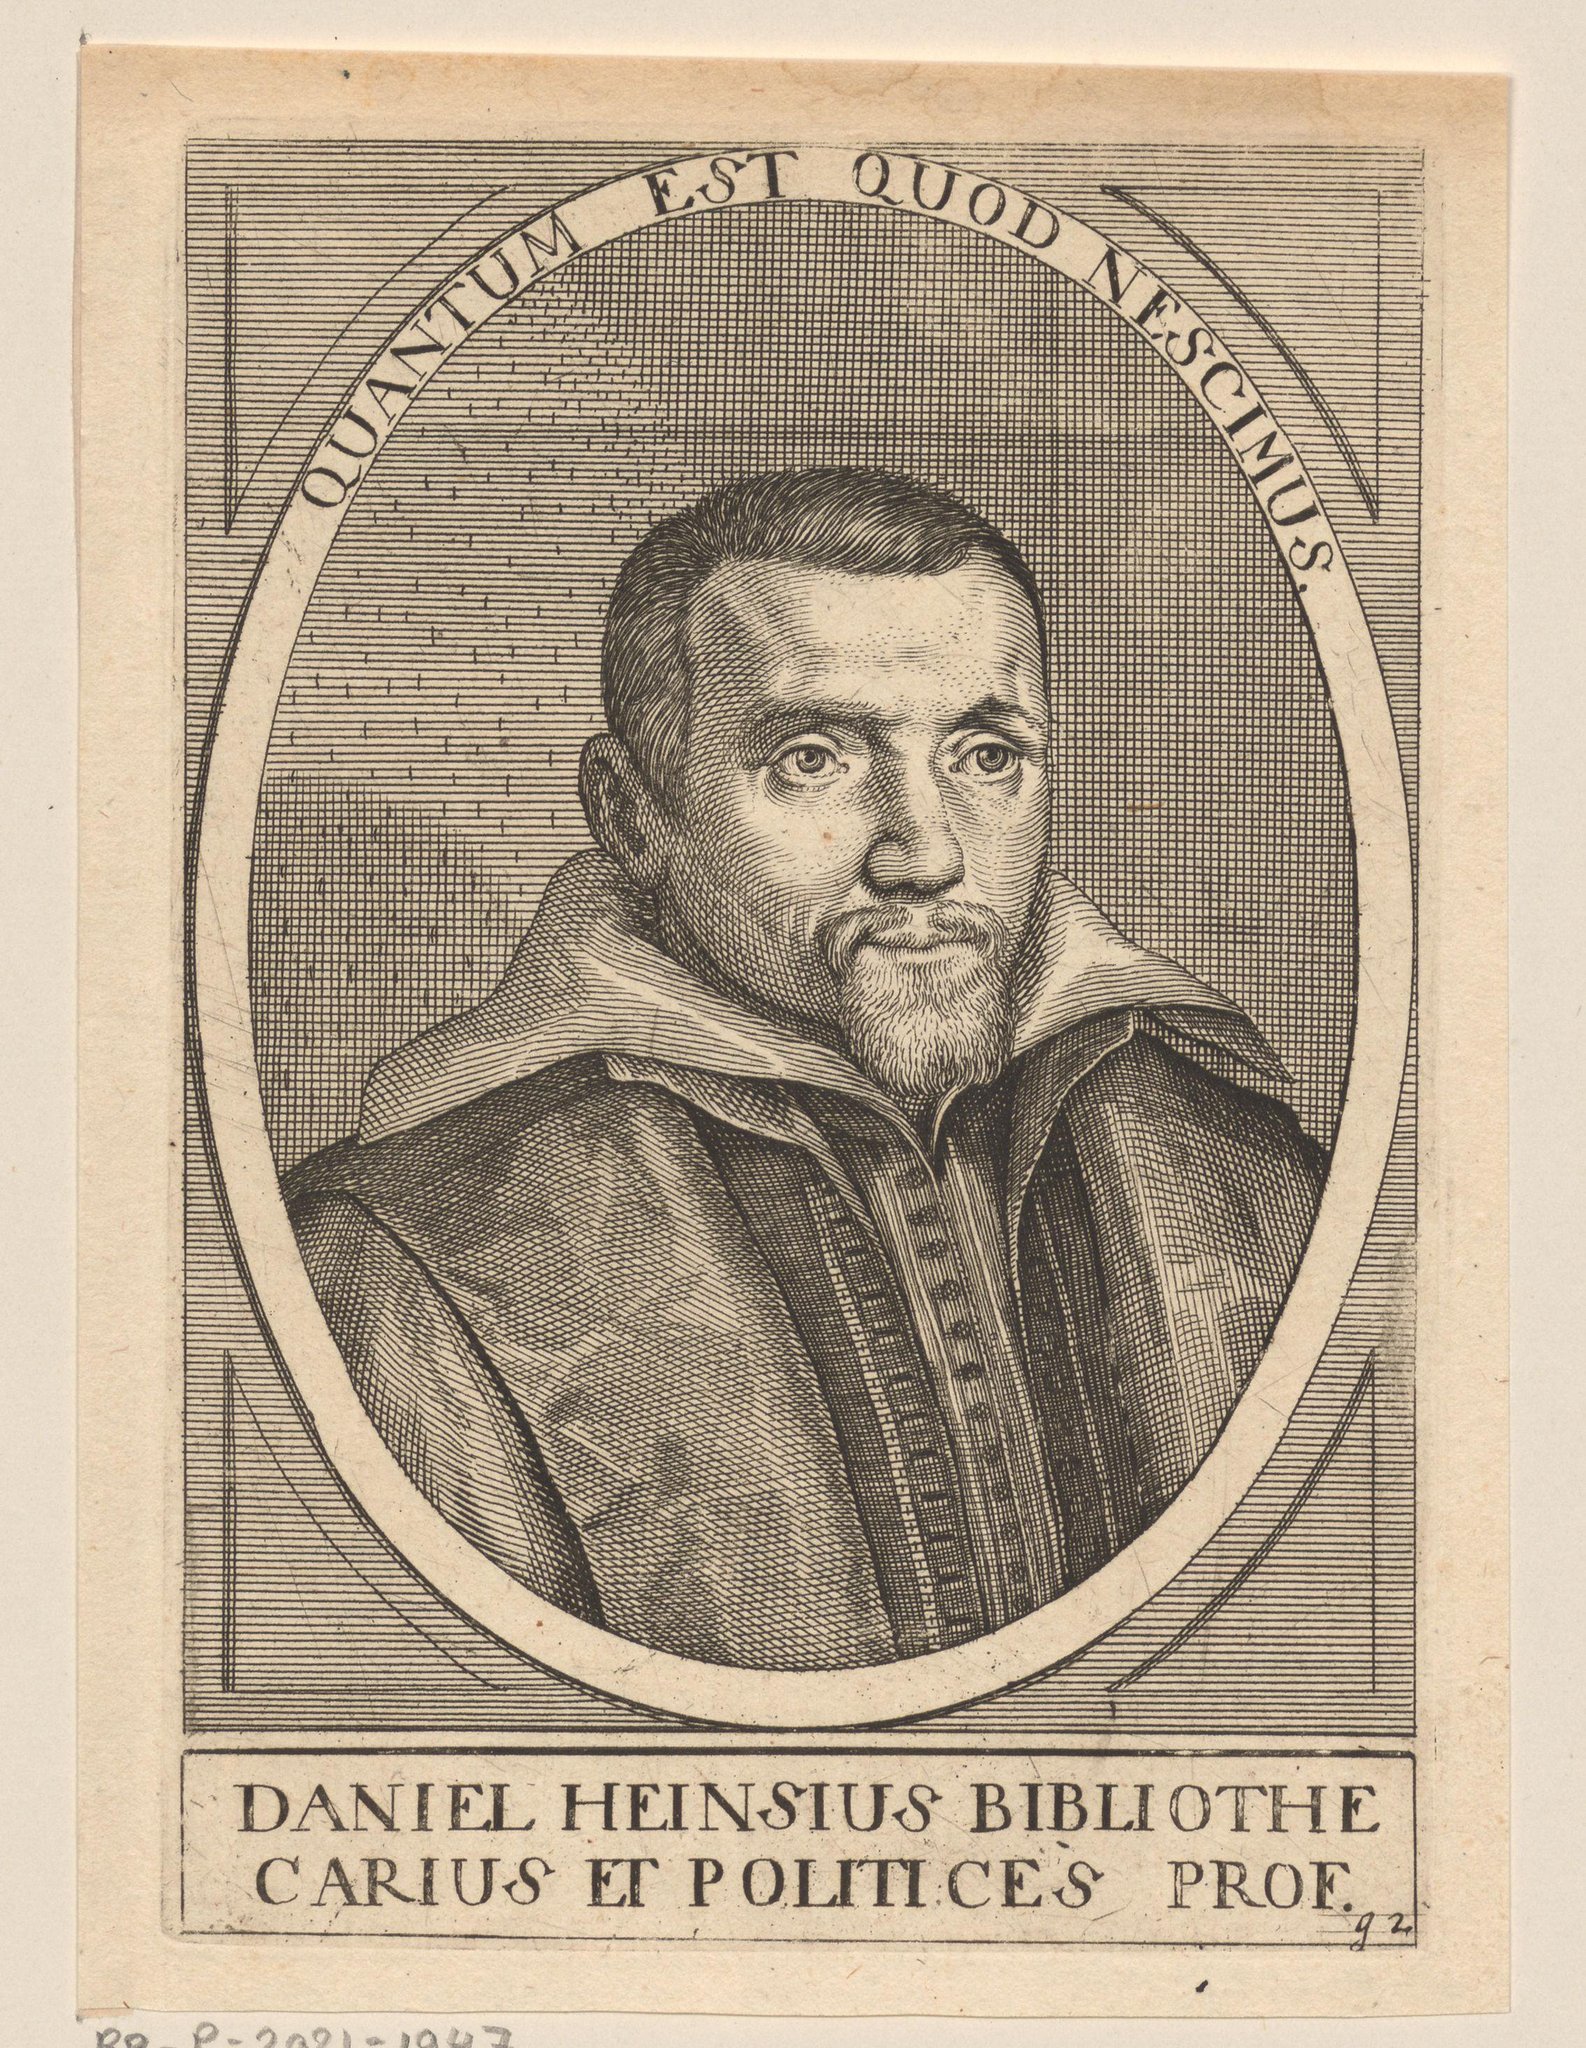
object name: print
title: Portret van Daniël Heinsius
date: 1650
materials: paper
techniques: engraving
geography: frankfurt am main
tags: ghent, leiden, daniël heinsius, scholar, philosopher, historical persons